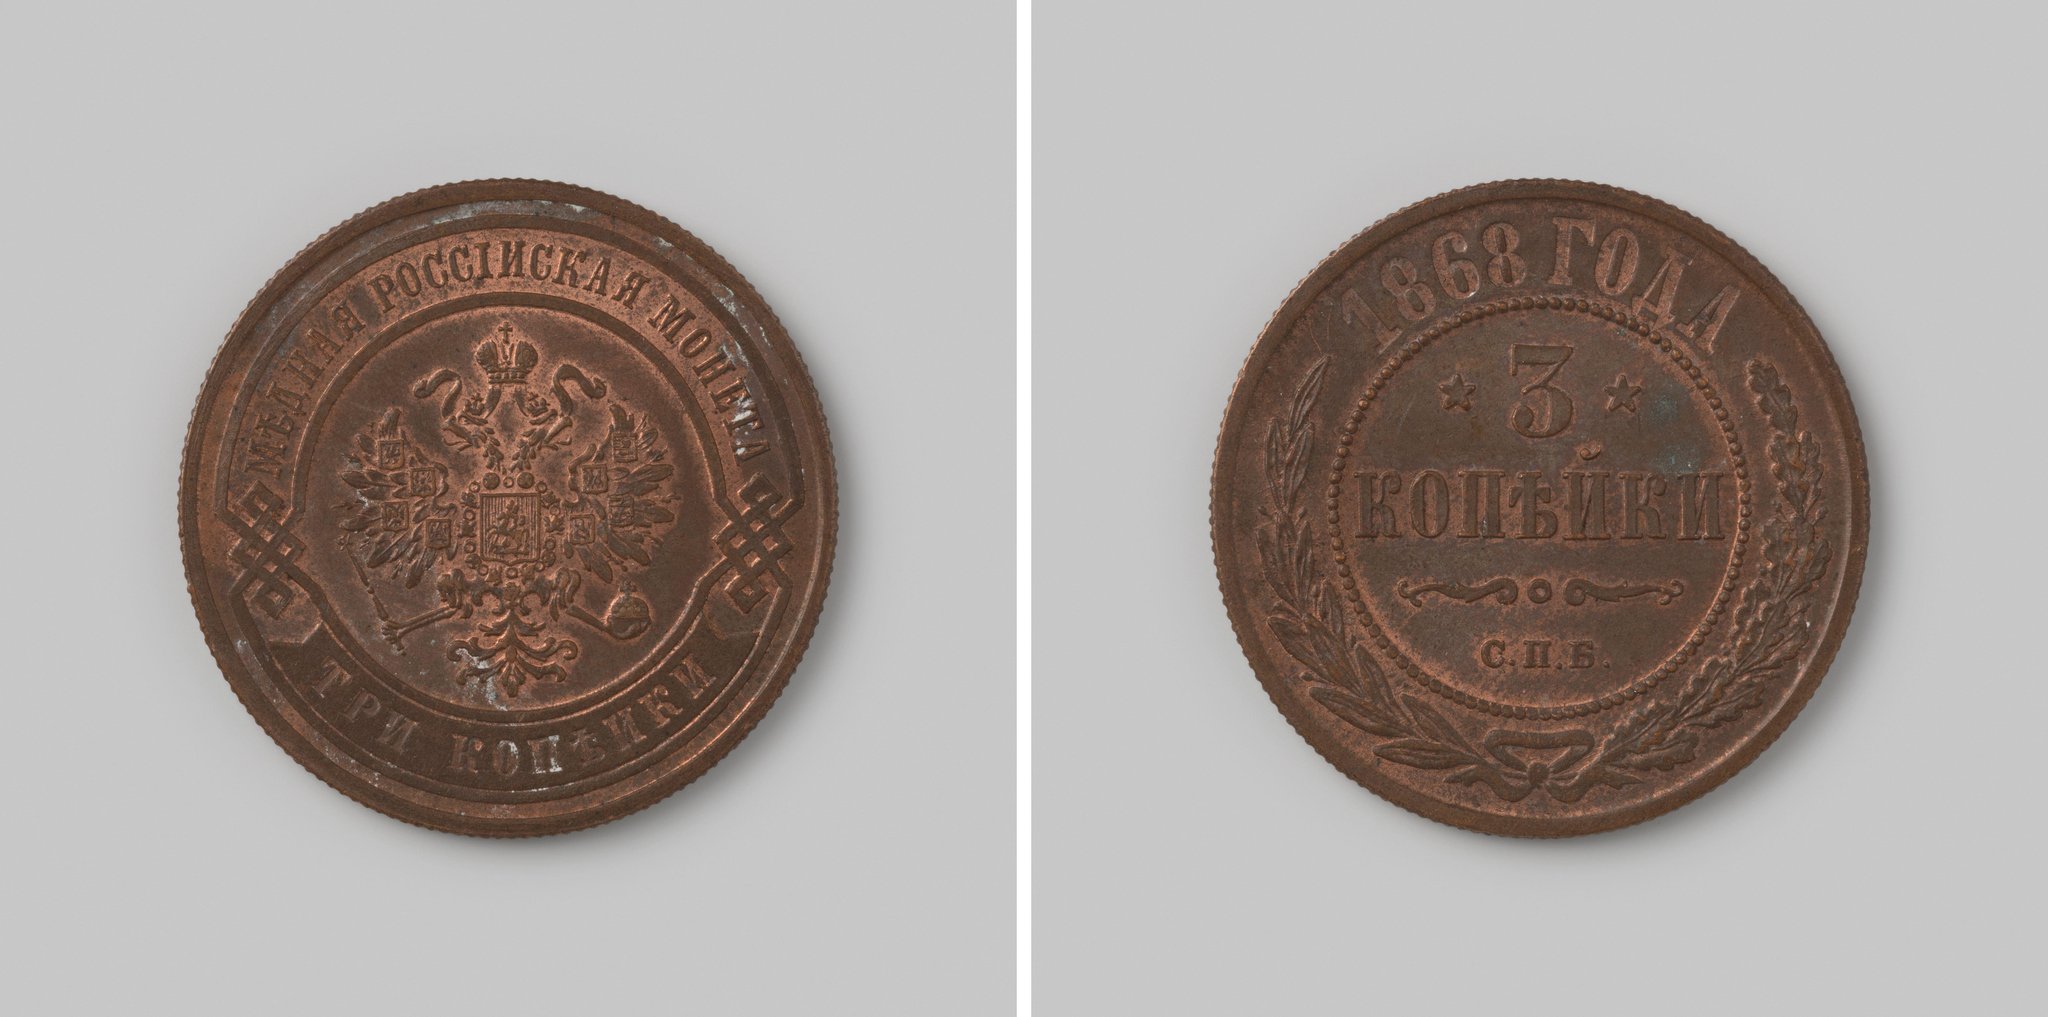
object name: coin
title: 3 kopeken uit Rusland van tsaar Alexander II, 1868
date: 1868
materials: copper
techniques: striking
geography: sint-petersburg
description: Koperen munt. Voorzijde: dubbelkoppige gekroonde adelaar met gespreide vleugels en met op zijn vleugels kleine wapenschilden en op zijn borst een groot, met een ridderorde omhangen wapenschild en in zijn poten een scepter en een gekroonde bol. Boven de adelaar een kroon met lint. Waarde-aanduiding in omschrift onderaan. Keerzijde: tussen twee samengebonden takken in twee regels waarde-aanduiding. Daaronder in het Cyrillisch de letters S,P en B [=Sint Petersburg]. Jaartal bovenaan in omschrift. Kartelrand.